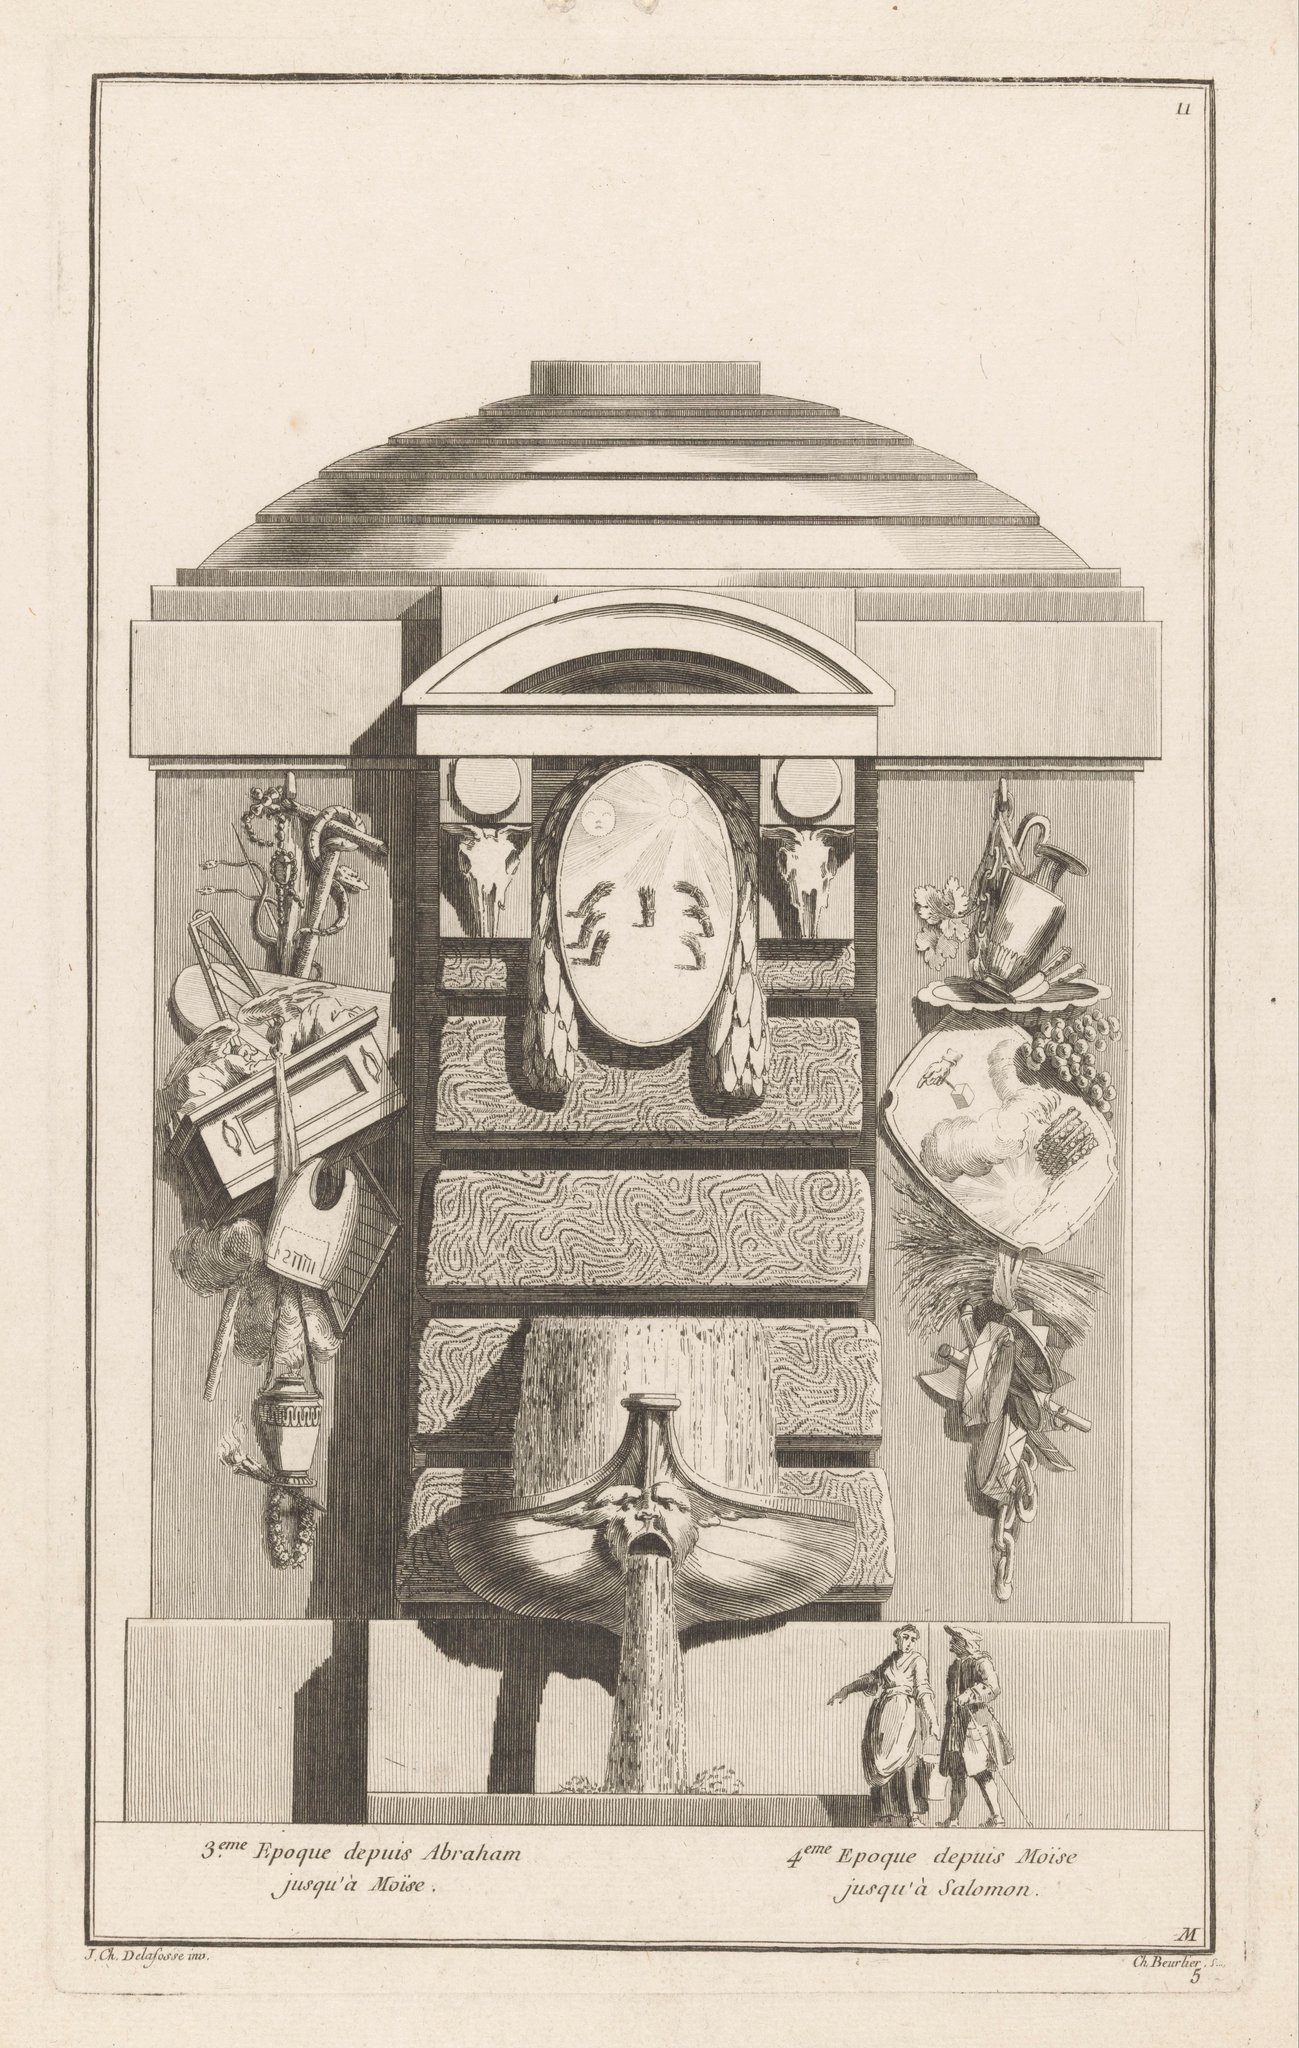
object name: print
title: Abraham, Mozes en Salomo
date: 1768-1771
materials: paper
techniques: engraving, etching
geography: paris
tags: story of abraham, moses (not in biblical context); possible attributes: rays of light or horns on his head, rod, tables of the law, ornamental fountain, solomon (not in biblical context); possible attributes of solomon: crown, sceptre, sword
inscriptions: collector's mark: Lugt 2760, collector's mark: Lugt 2228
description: Een man en een vrouw bevinden zich voor een fontein met runderschedels en een medaillon met zeven bundels korenaren. Links en rechts omgeven door slangen, engelen op een grafkist, een mijter, een rookvat, een kan en een schaal, druiven, een schild met een brandende stapel hout en kronen. Prentnummer 11.